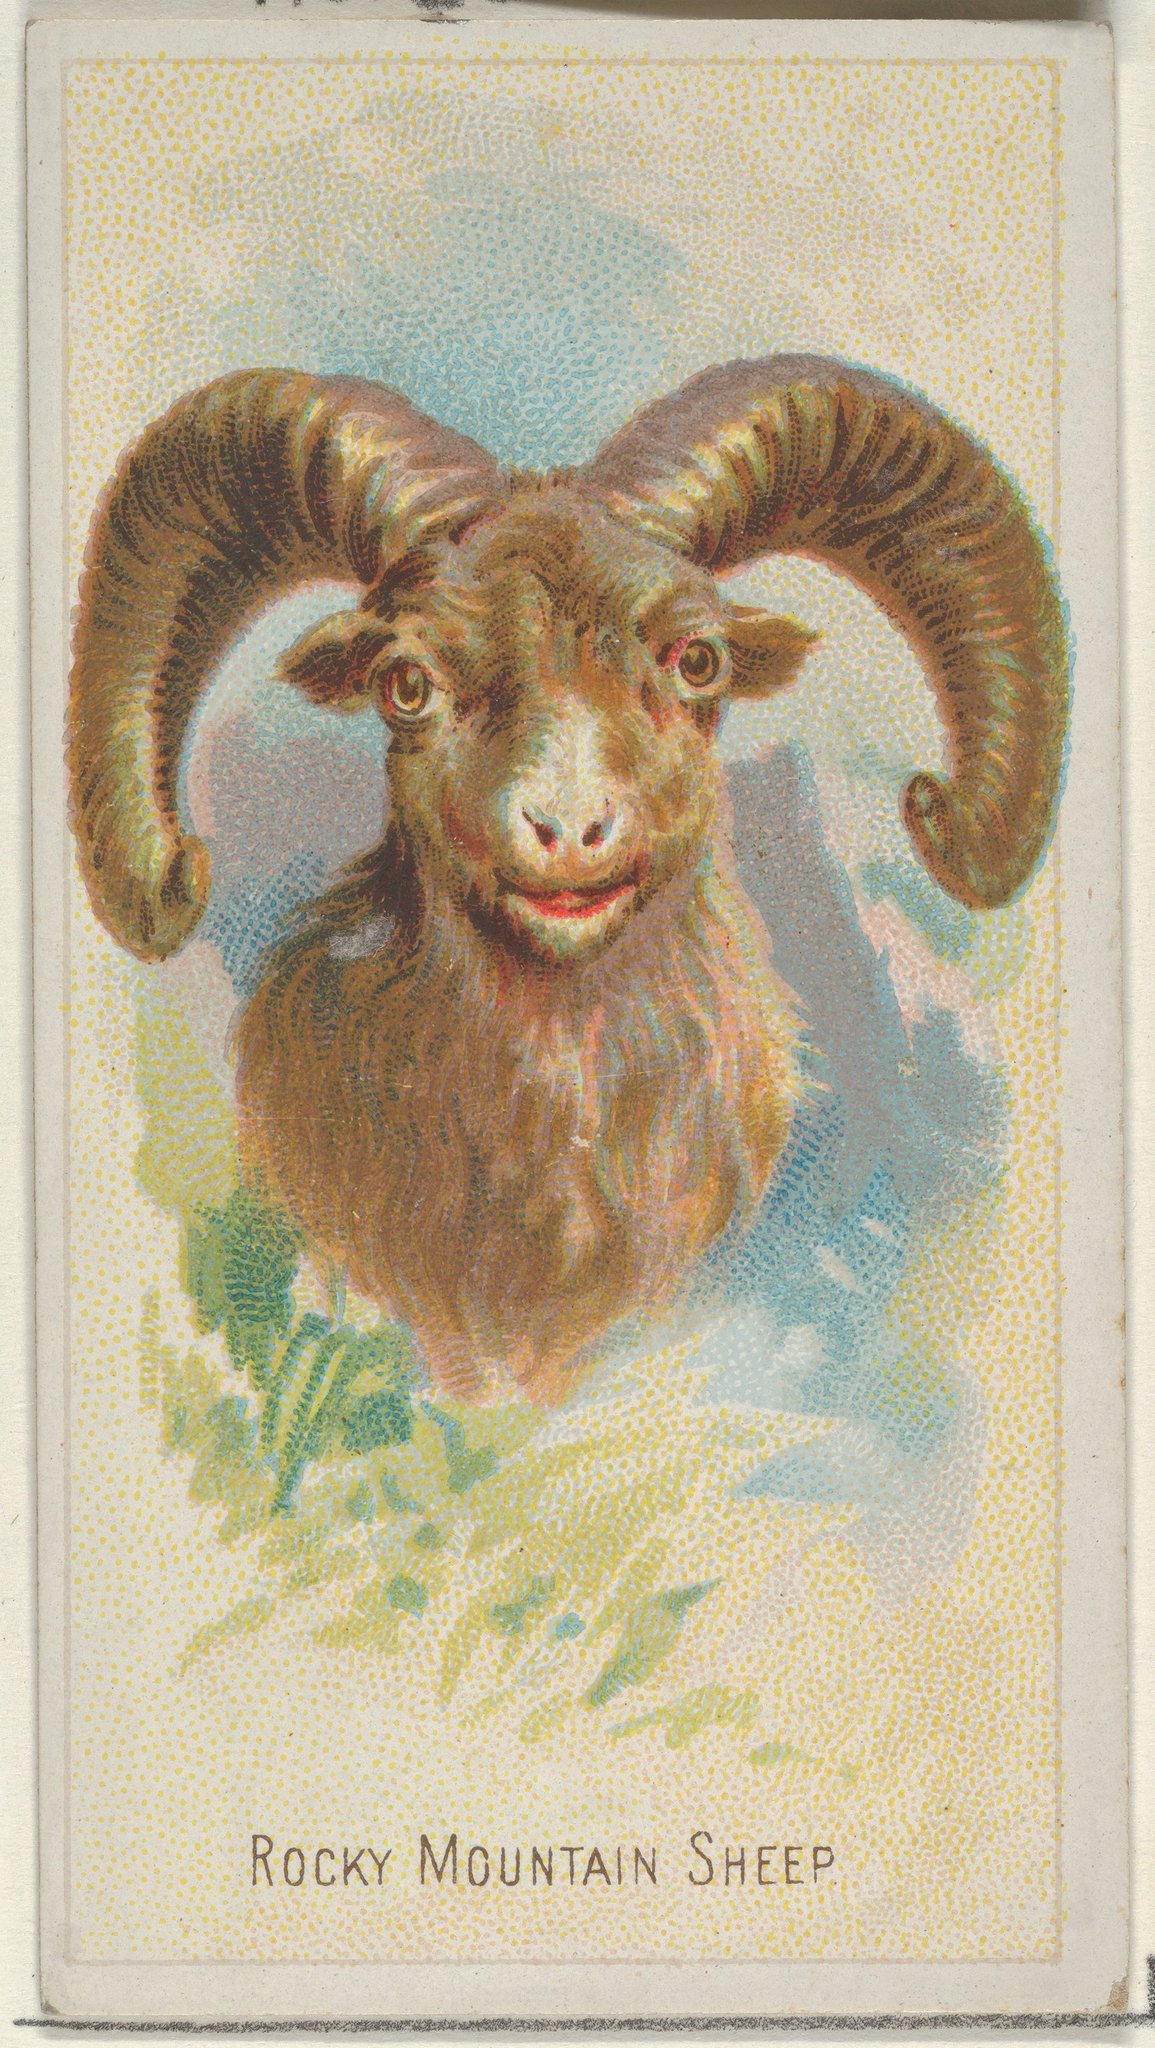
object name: print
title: Rocky Mountain Sheep, from the Wild Animals of the World series (N25) for Allen & Ginter Cigarettes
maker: allen & ginter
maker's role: publisher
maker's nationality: american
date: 1888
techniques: color lithograph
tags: sheep